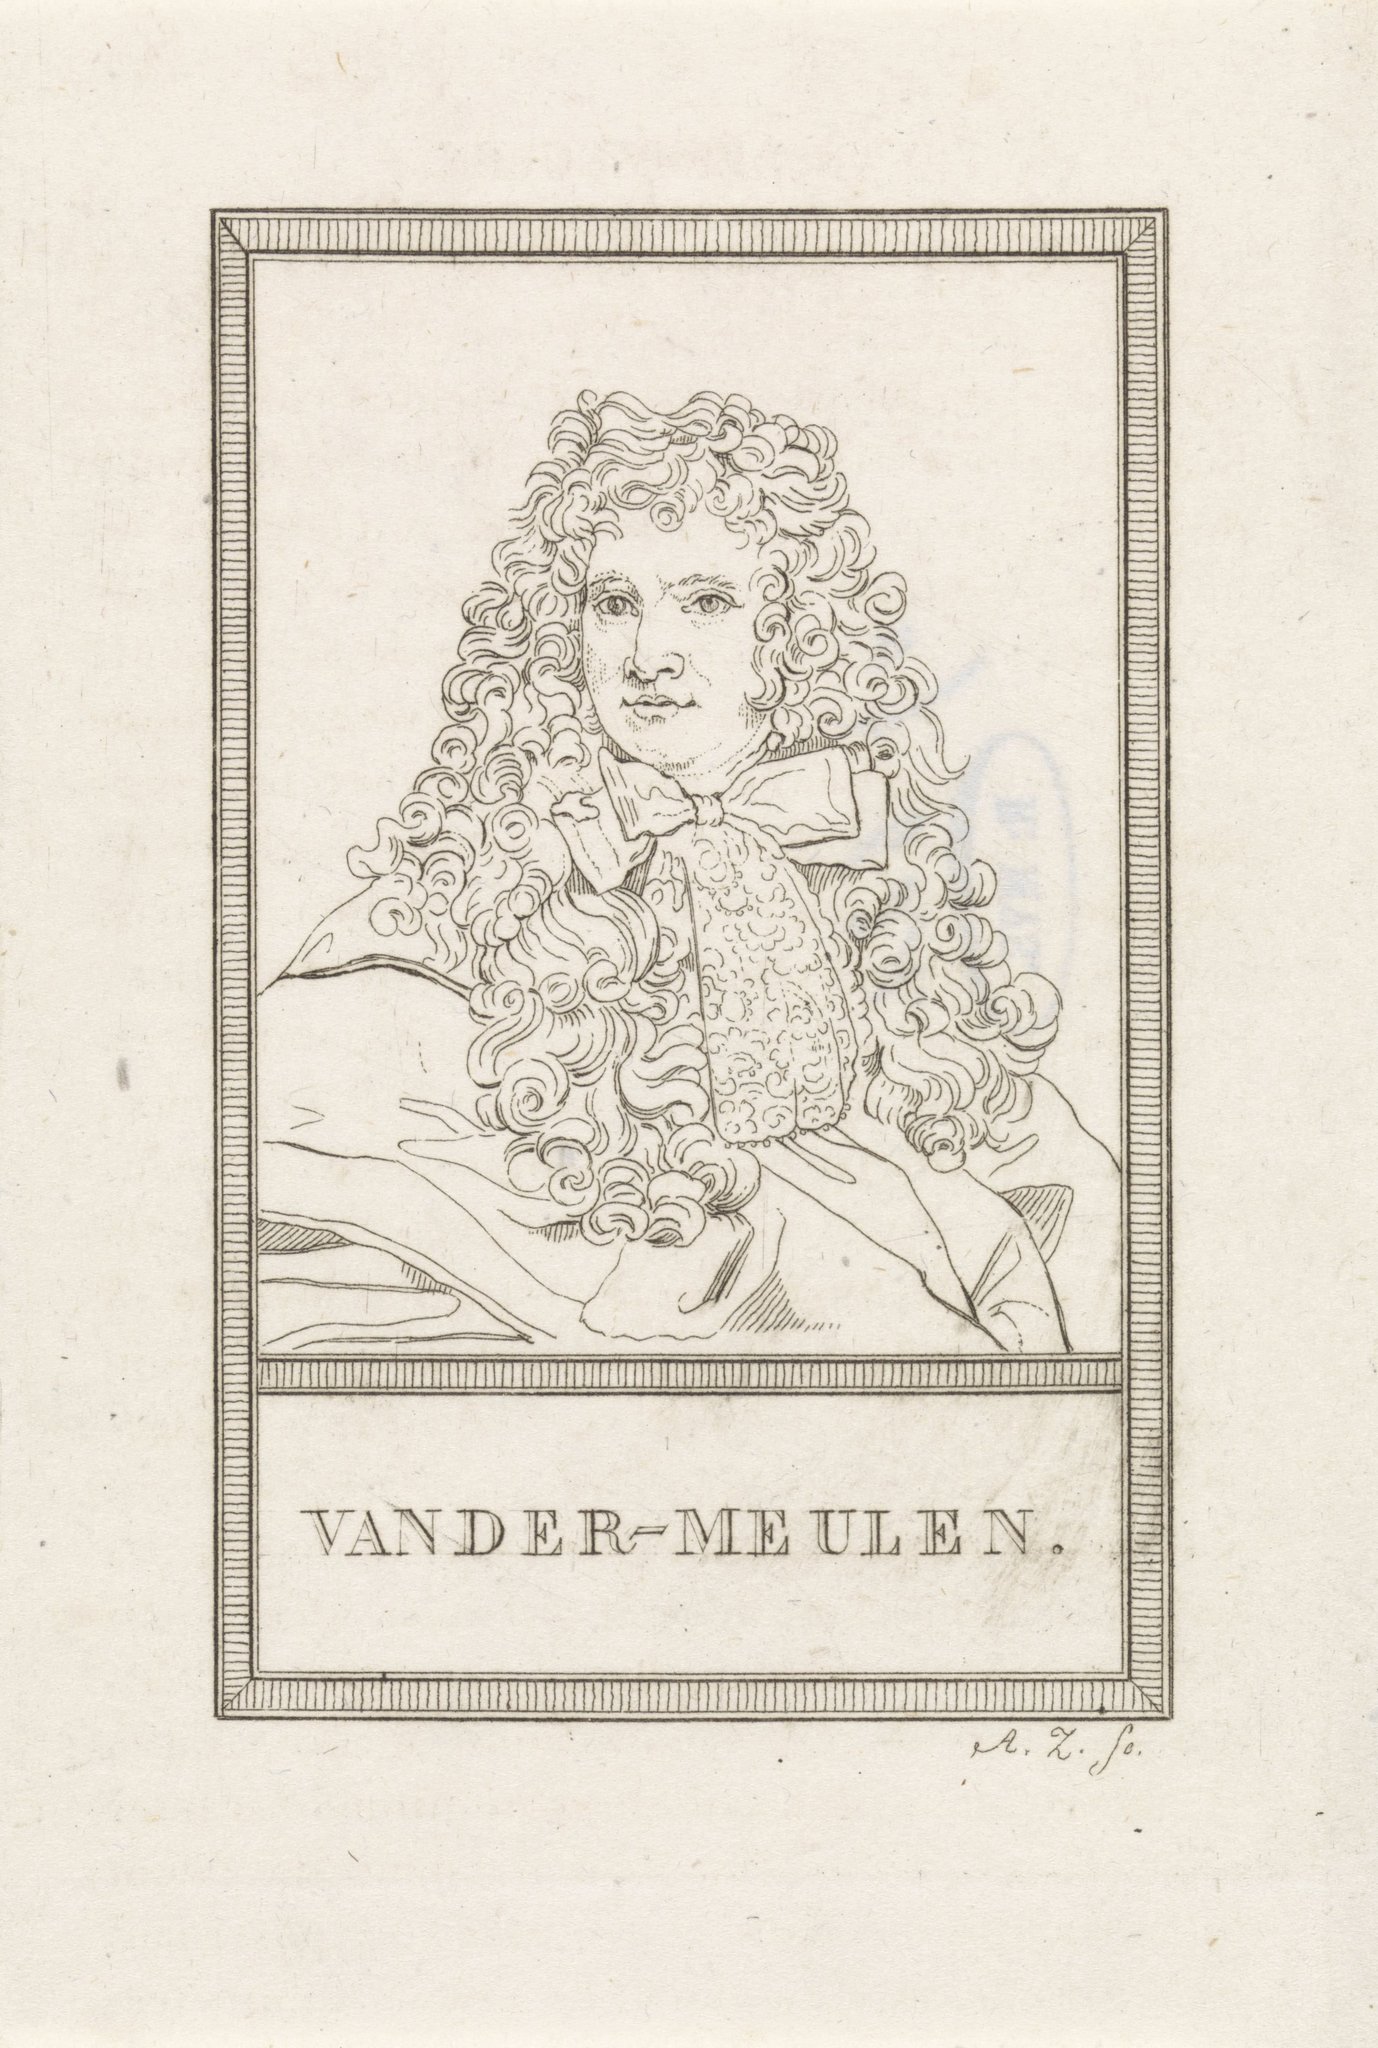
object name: print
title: Portret van schilder Adam Frans van der Meulen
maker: abraham lion zeelander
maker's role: draughtsman, print maker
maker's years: 1789-1856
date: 1799-1856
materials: paper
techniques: etching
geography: amsterdam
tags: brussels, paris, painter, draughtsman, publisher, adam frans van der meulen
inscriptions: collector's mark: Lugt 2228